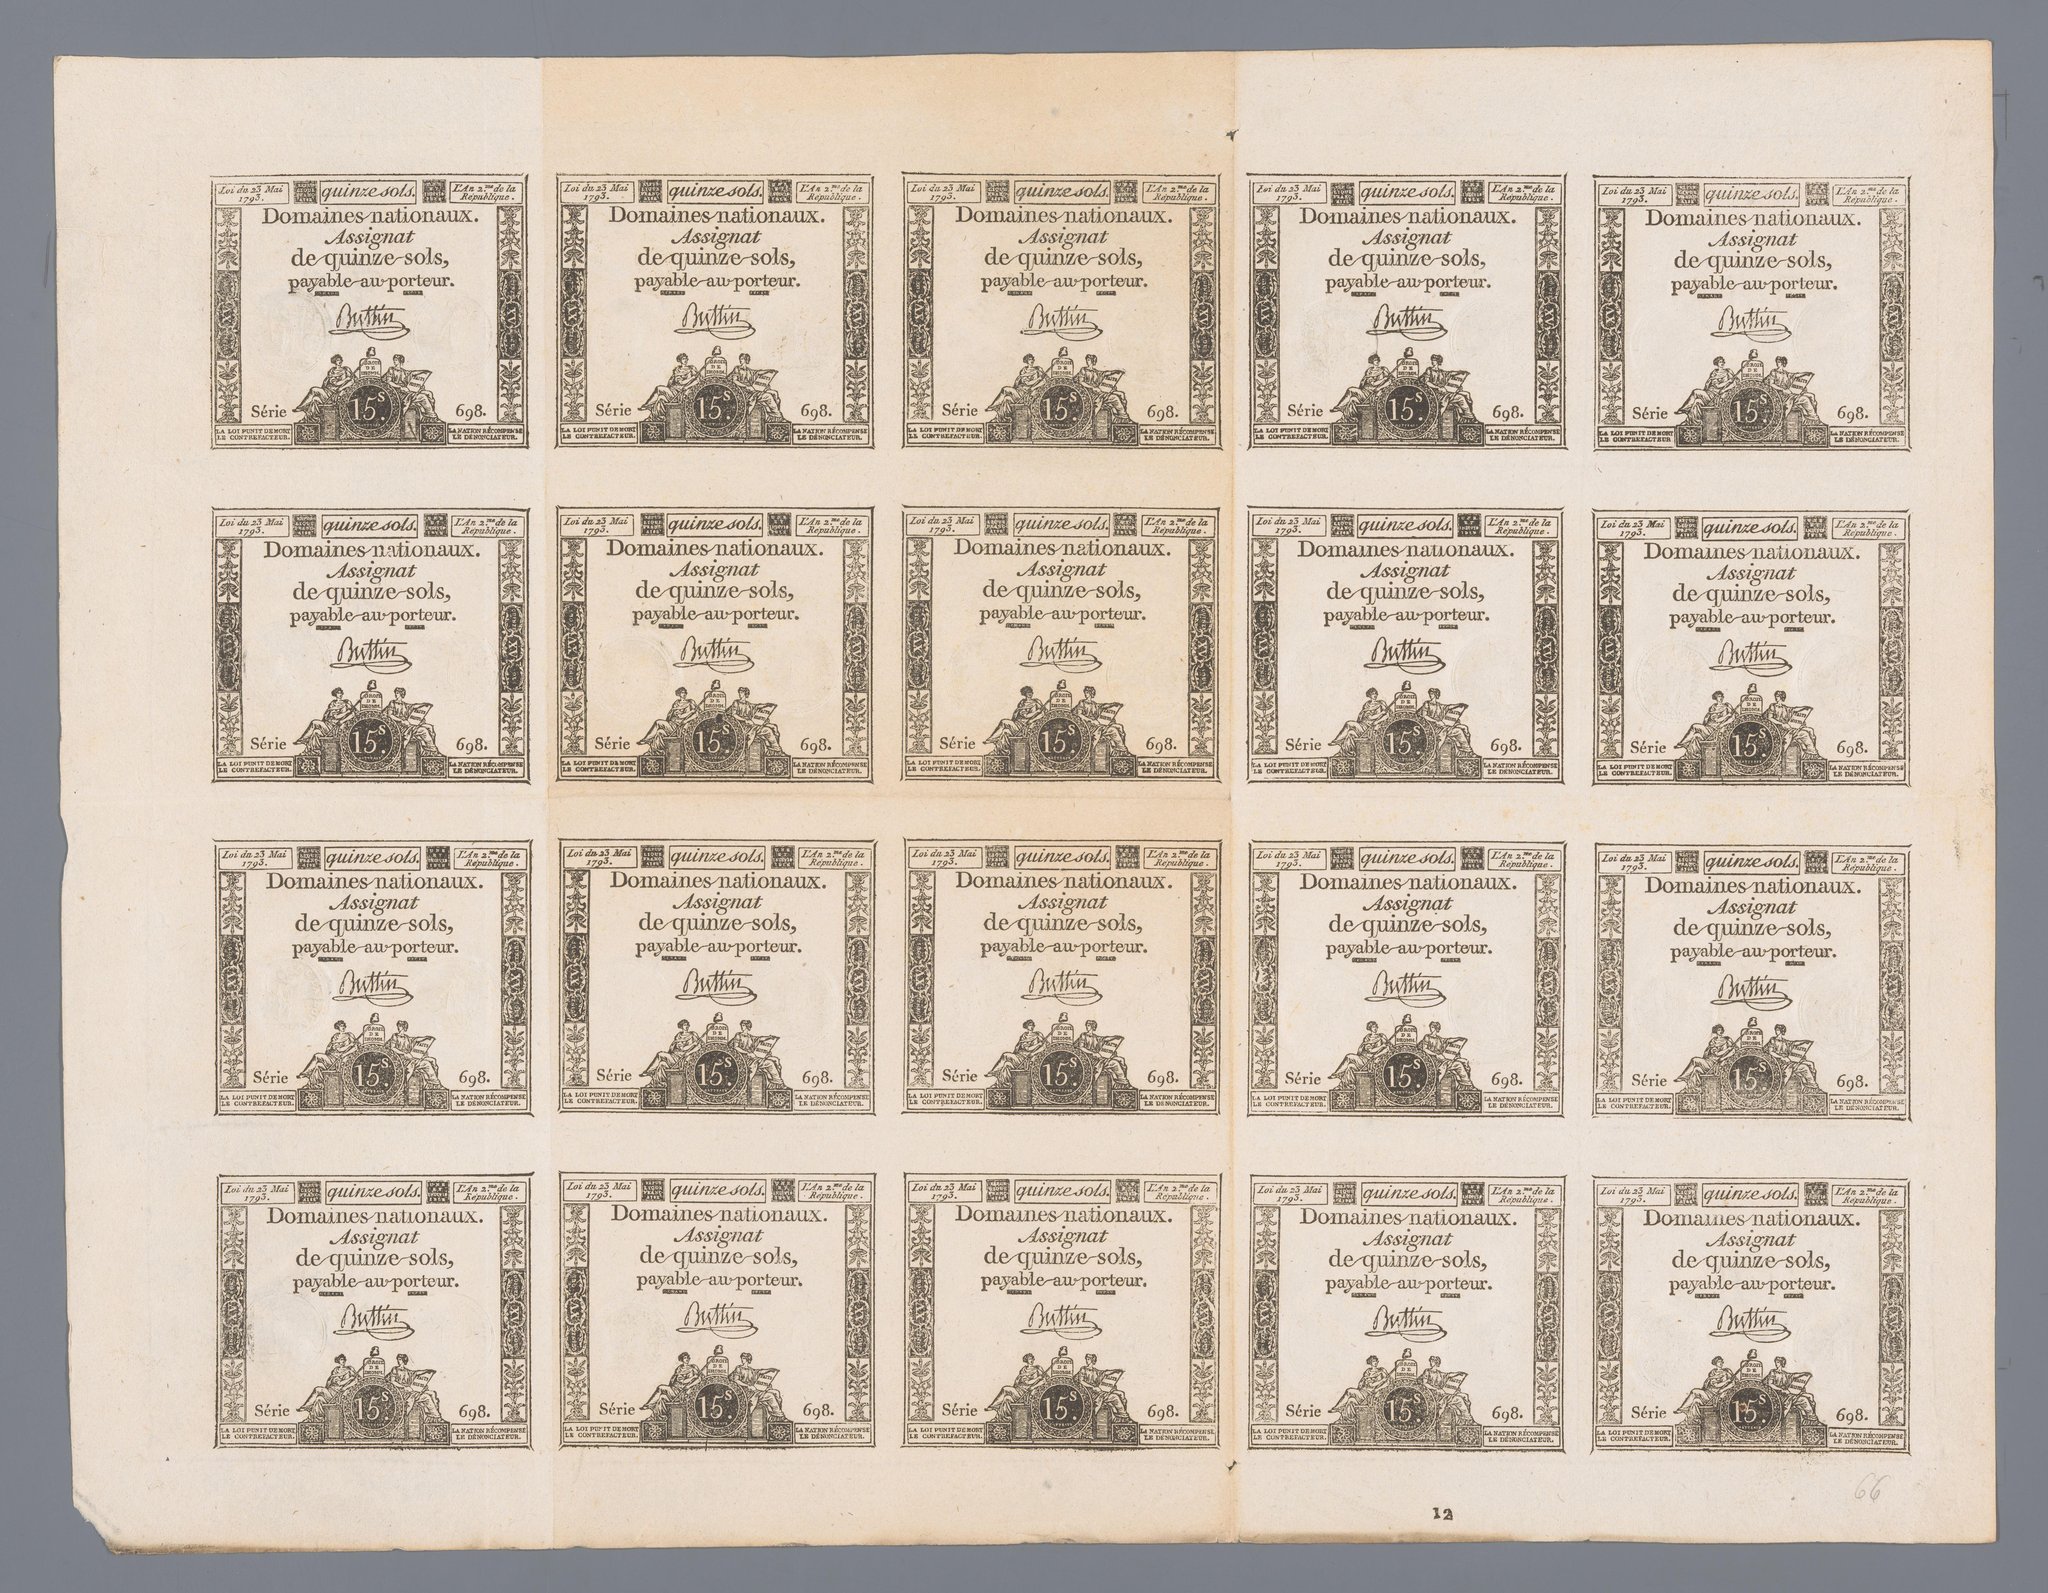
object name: assignat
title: Vel met 20 assignaten van vijftien sols, serie 698 uitgegeven 23 mei 1793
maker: nicolas marie gatteaux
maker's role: medailleur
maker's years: 1751-1832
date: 1793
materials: paper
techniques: printing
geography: france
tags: bank-note, france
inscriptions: signature: ‘Buttin’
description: Vel met 20 franse assignaten uit de serie 698 à 15 sols, gesigneerd door Buttin, eenzijdig bedrukt. Gesigneerd. Gedatereerd: 23-5-1793. Gemerkt: reliëfstempel.